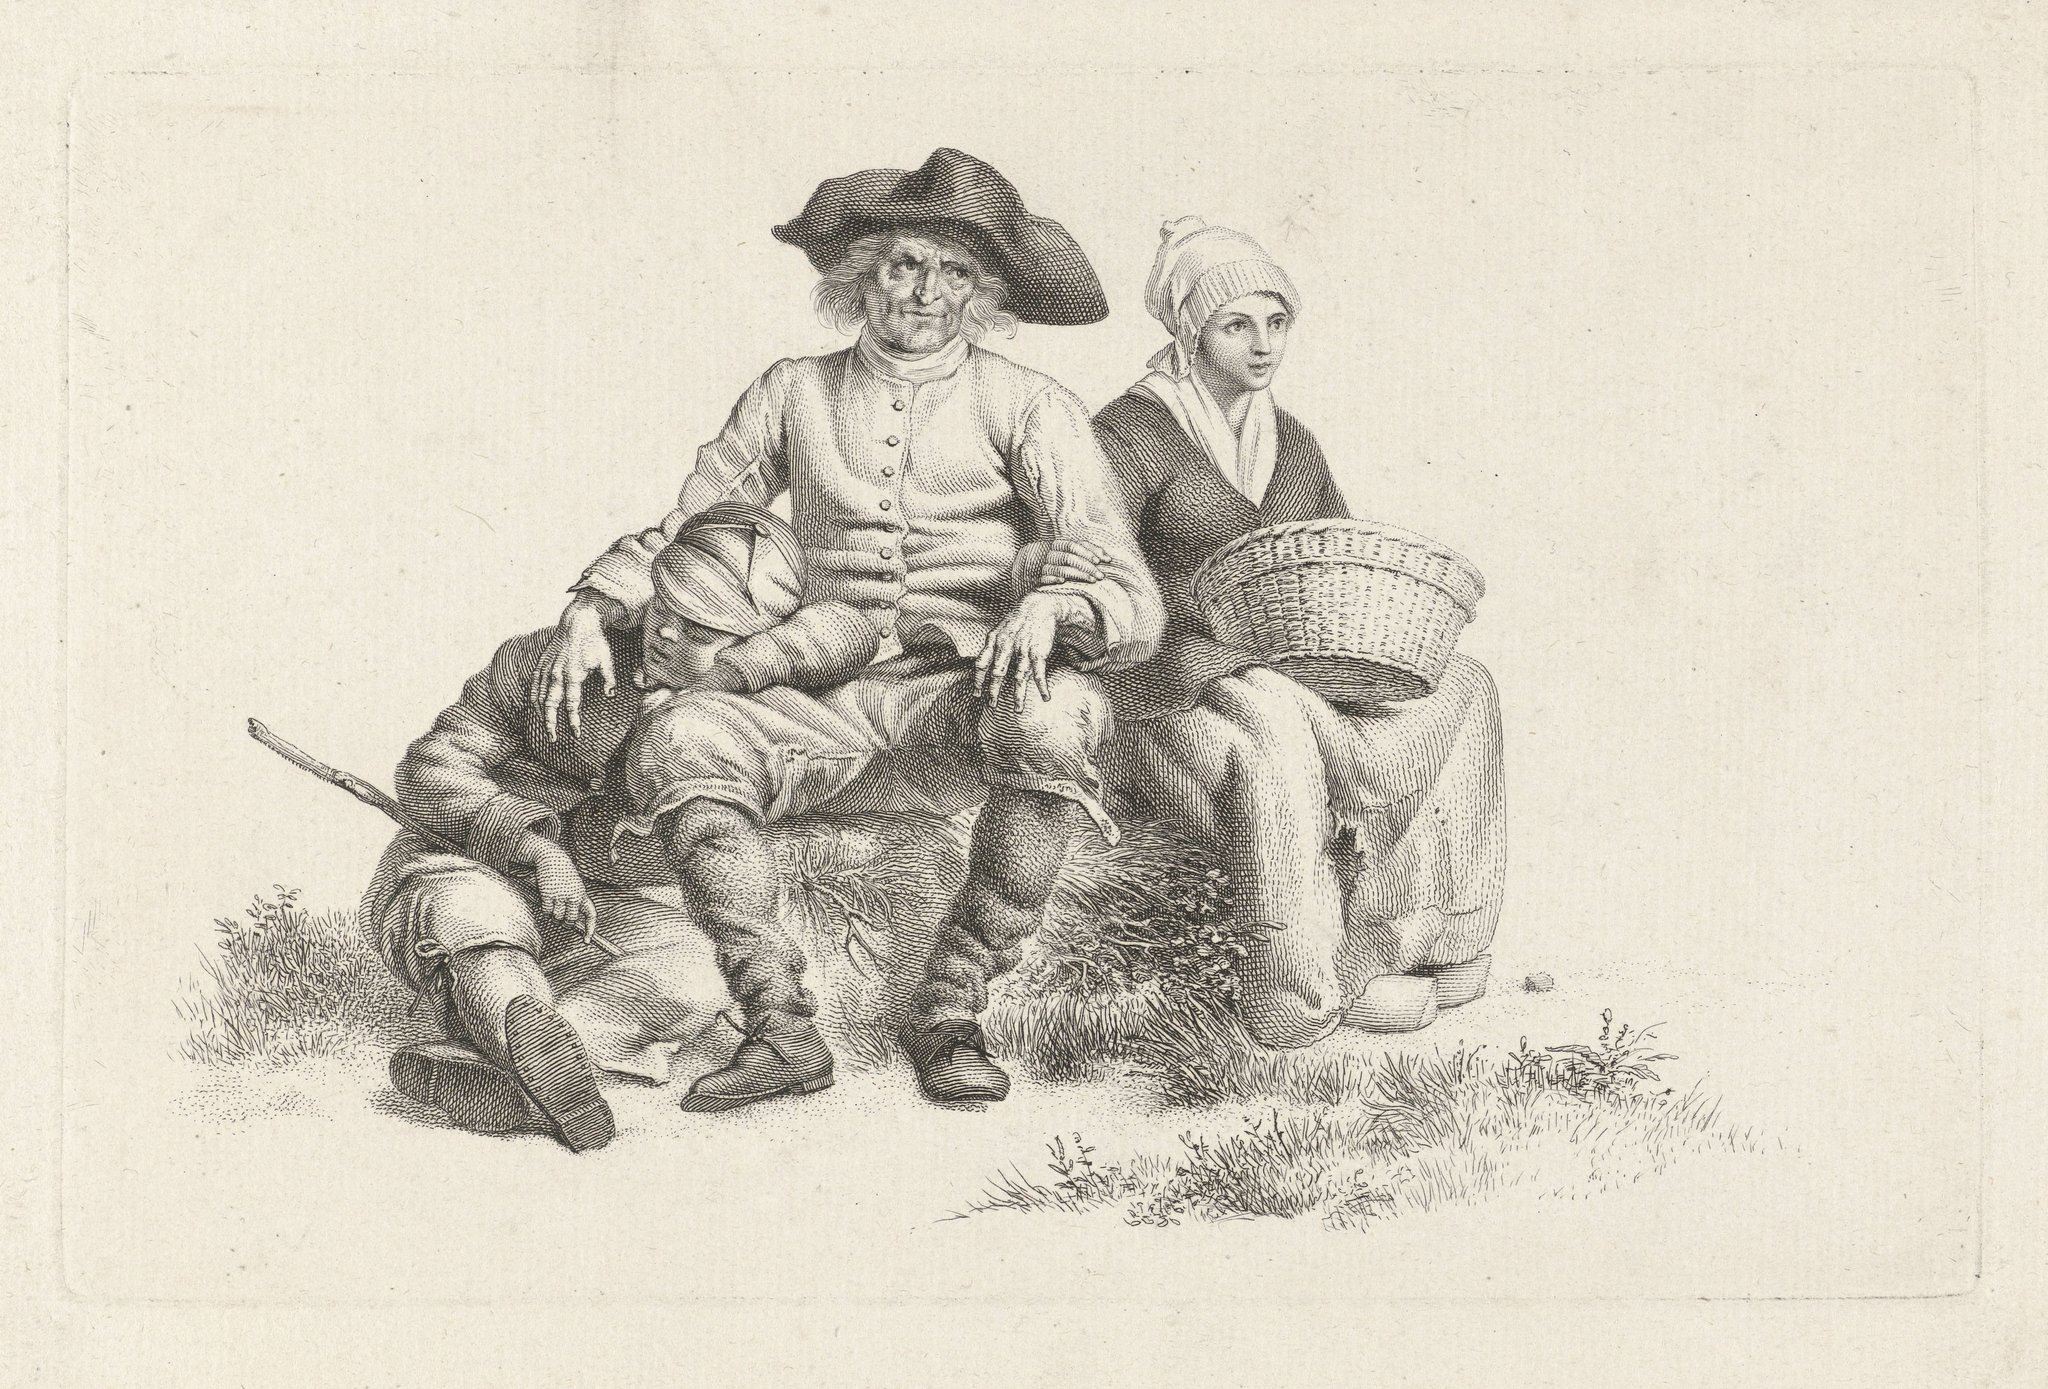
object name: print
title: Studie-prentwerk / Etudes gravées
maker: jacob ernst marcus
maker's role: draughtsman, print maker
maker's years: 1774-1826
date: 1805-1815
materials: paper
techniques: etching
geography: amsterdam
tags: boy (child between toddler and youth) (+ sitting on the ground), family group, especially parents with their child(ren), container made of plant material other than wood: basket, sleeping; unconsciousness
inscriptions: collector's mark: Lugt 2228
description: Serie voor het eerst uitgegeven door Jacob Ernst Marcus onder de titel Studiebeelden en Fragmenten. Amsterdam: ca.1816. Later heruitgegeven als: Studie-prentwerk/ Etudes gravées.